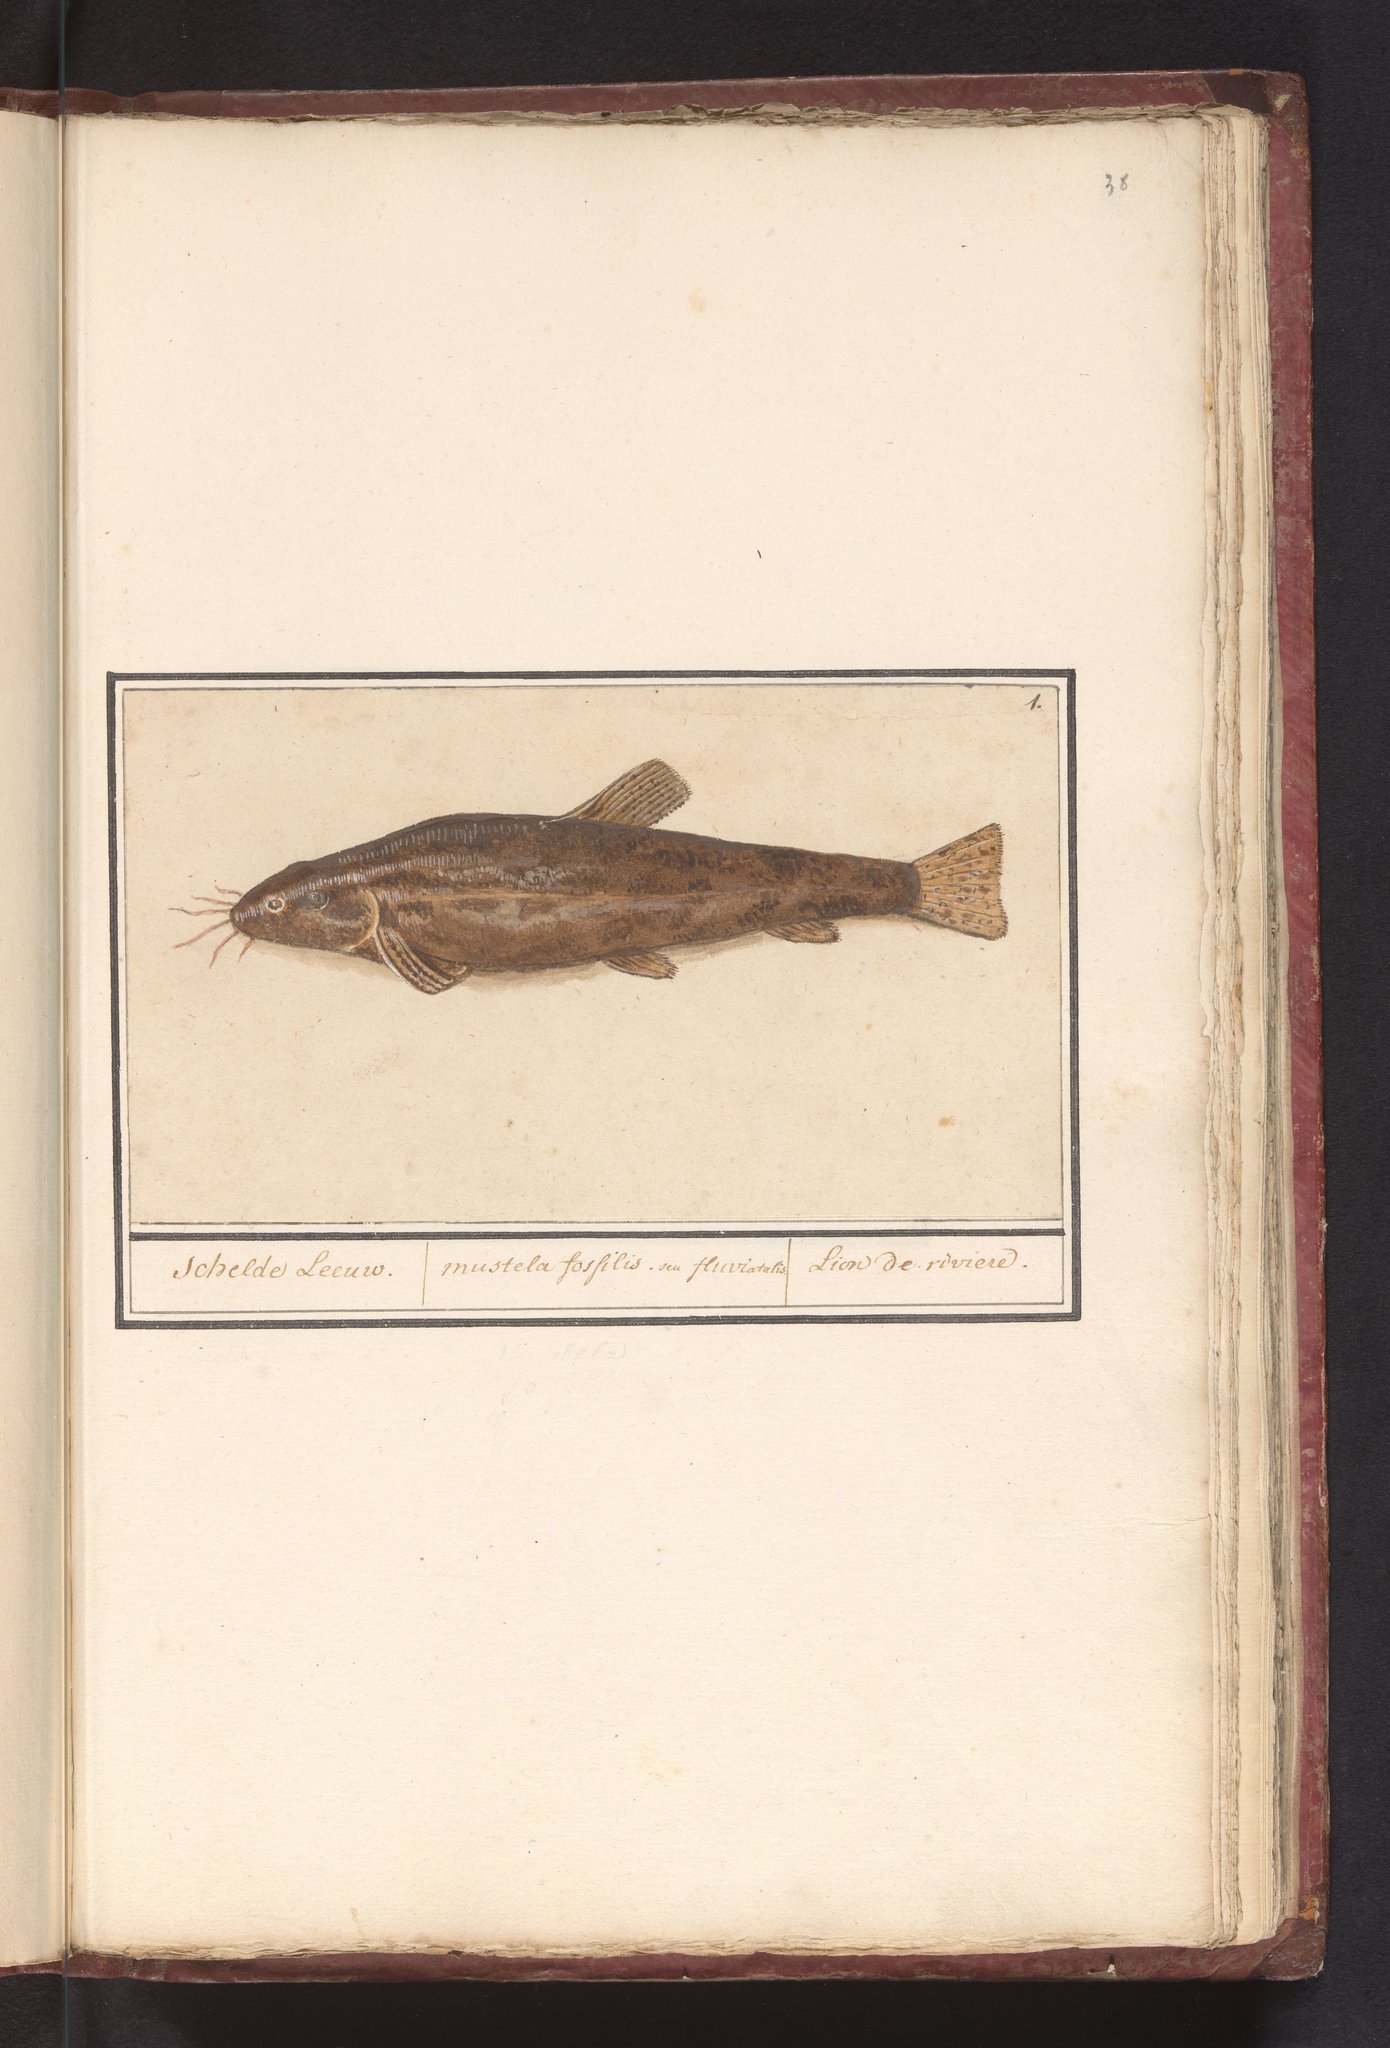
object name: drawing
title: Schelde Leeuw. / mustela fosfilis. seu fluviatalis / Lion de riviere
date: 1596-1610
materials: chalk, paint, paper, pencil, watercolor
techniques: brush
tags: bony fishes: catfish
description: Meerval. Genummerd rechtsboven: 1. Onderdeel van het zesde album met tekeningen van vissen, schelpen en insekten. Zesde van twaalf albums met tekeningen van dieren, vogels en planten bekend rond 1600, gemaakt in opdracht van keizer Rudolf II. Met toelichting in Nederlands, Latijn en Frans.